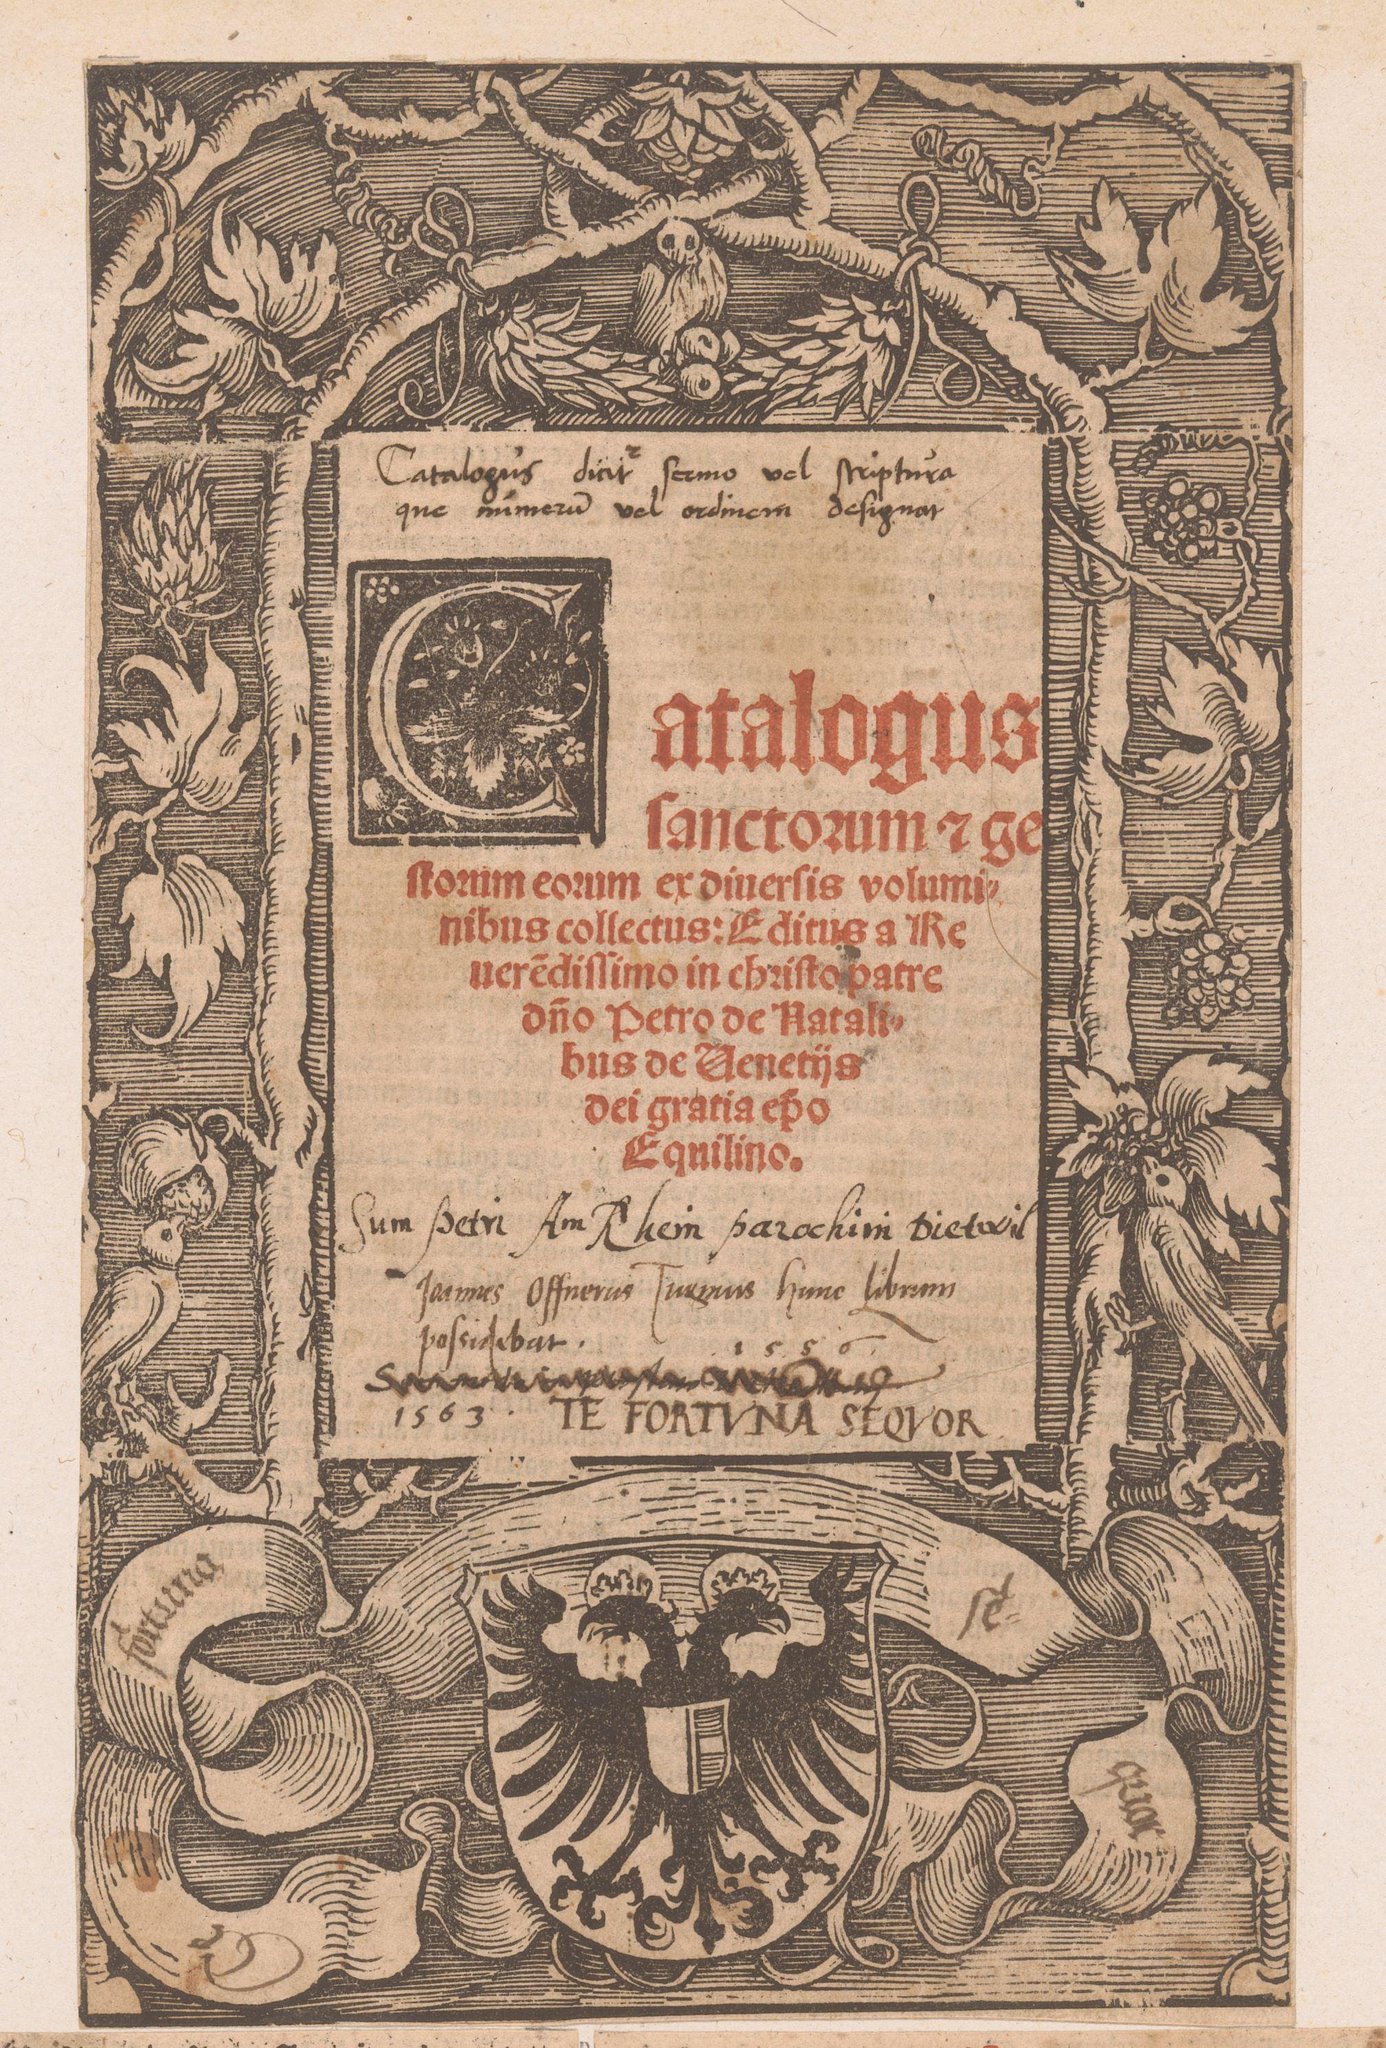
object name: print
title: Titelpagina met ranken, vogels en een wapenschild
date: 1511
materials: paper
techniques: letterpress printing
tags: vine, ornamental birds, title-page, armorial bearing, heraldry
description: Afkomstig uit: Natalibus, Petrus de. Catalogus Sanctorum. Straatsburg: Martinus Flach, 1513. Met twee stroken tekst in boekdruk op het opzetblad geplakt.